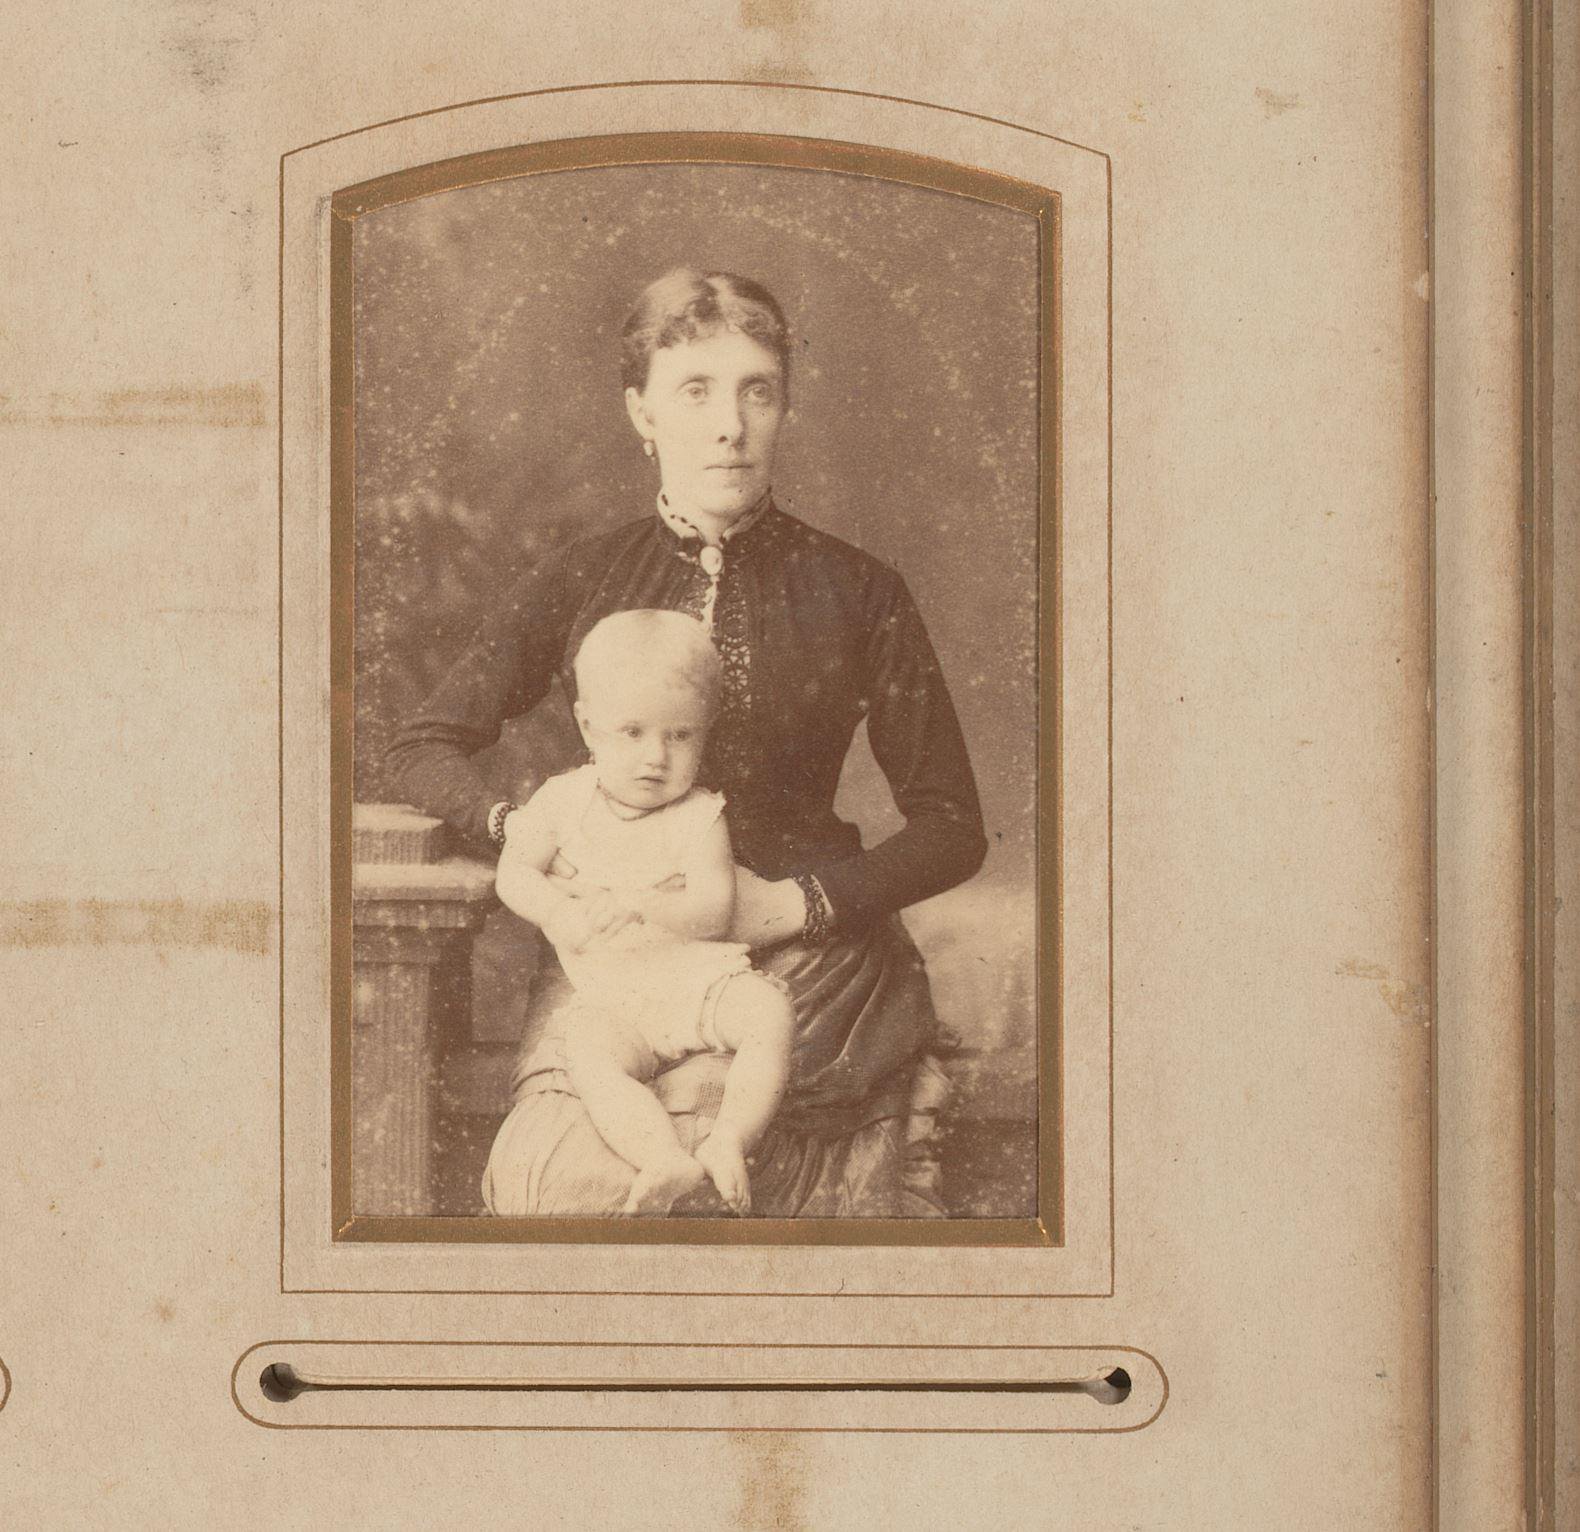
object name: photograph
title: Portret van een zittende vrouw met kind op schoot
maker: herman salzwedel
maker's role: fotograaf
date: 1880-1905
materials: cardboard, celluloid, photographic support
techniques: albumen print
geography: surabaya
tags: sitting figure - aa - female human figure, historical persons - bb - woman, tot, toddler ~ the ages of man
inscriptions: inscription: ‘(...)/ ATELIER/ van/ H. SALZWEDEL/ SOERABAYA/ JAVA./ Het cliché blijft voor nabestelling bewaard.’